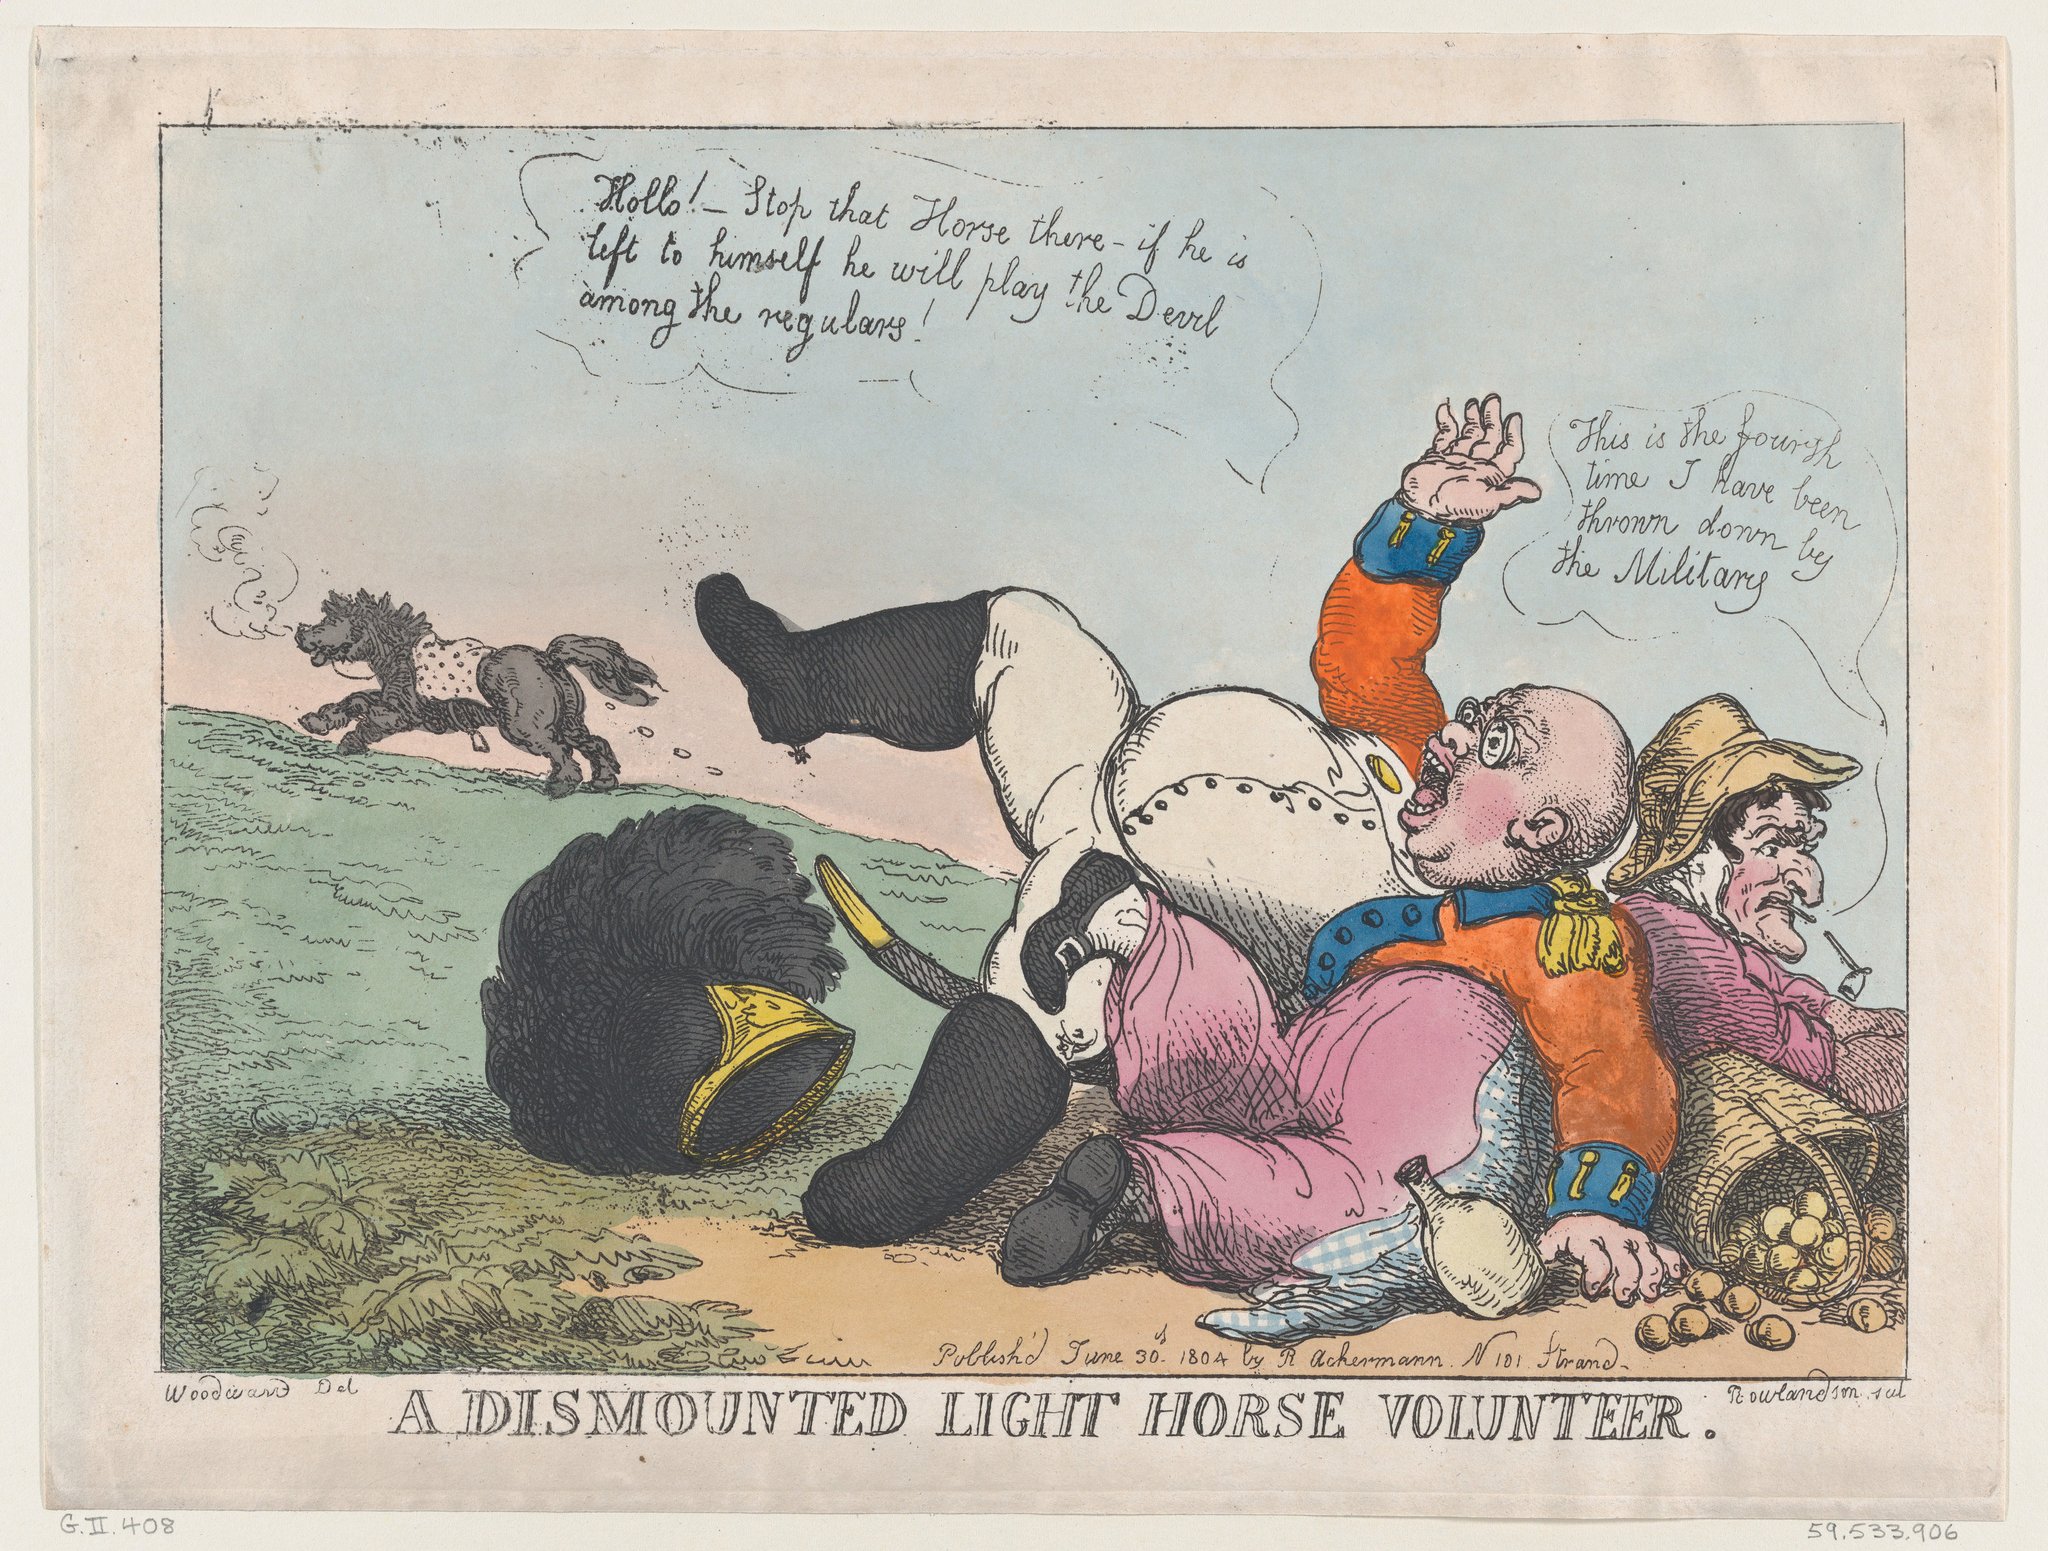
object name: print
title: A Dismounted Light Horse Volunteer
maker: thomas rowlandson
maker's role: artist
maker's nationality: british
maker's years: 1757-1827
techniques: etching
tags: satire,men,horses